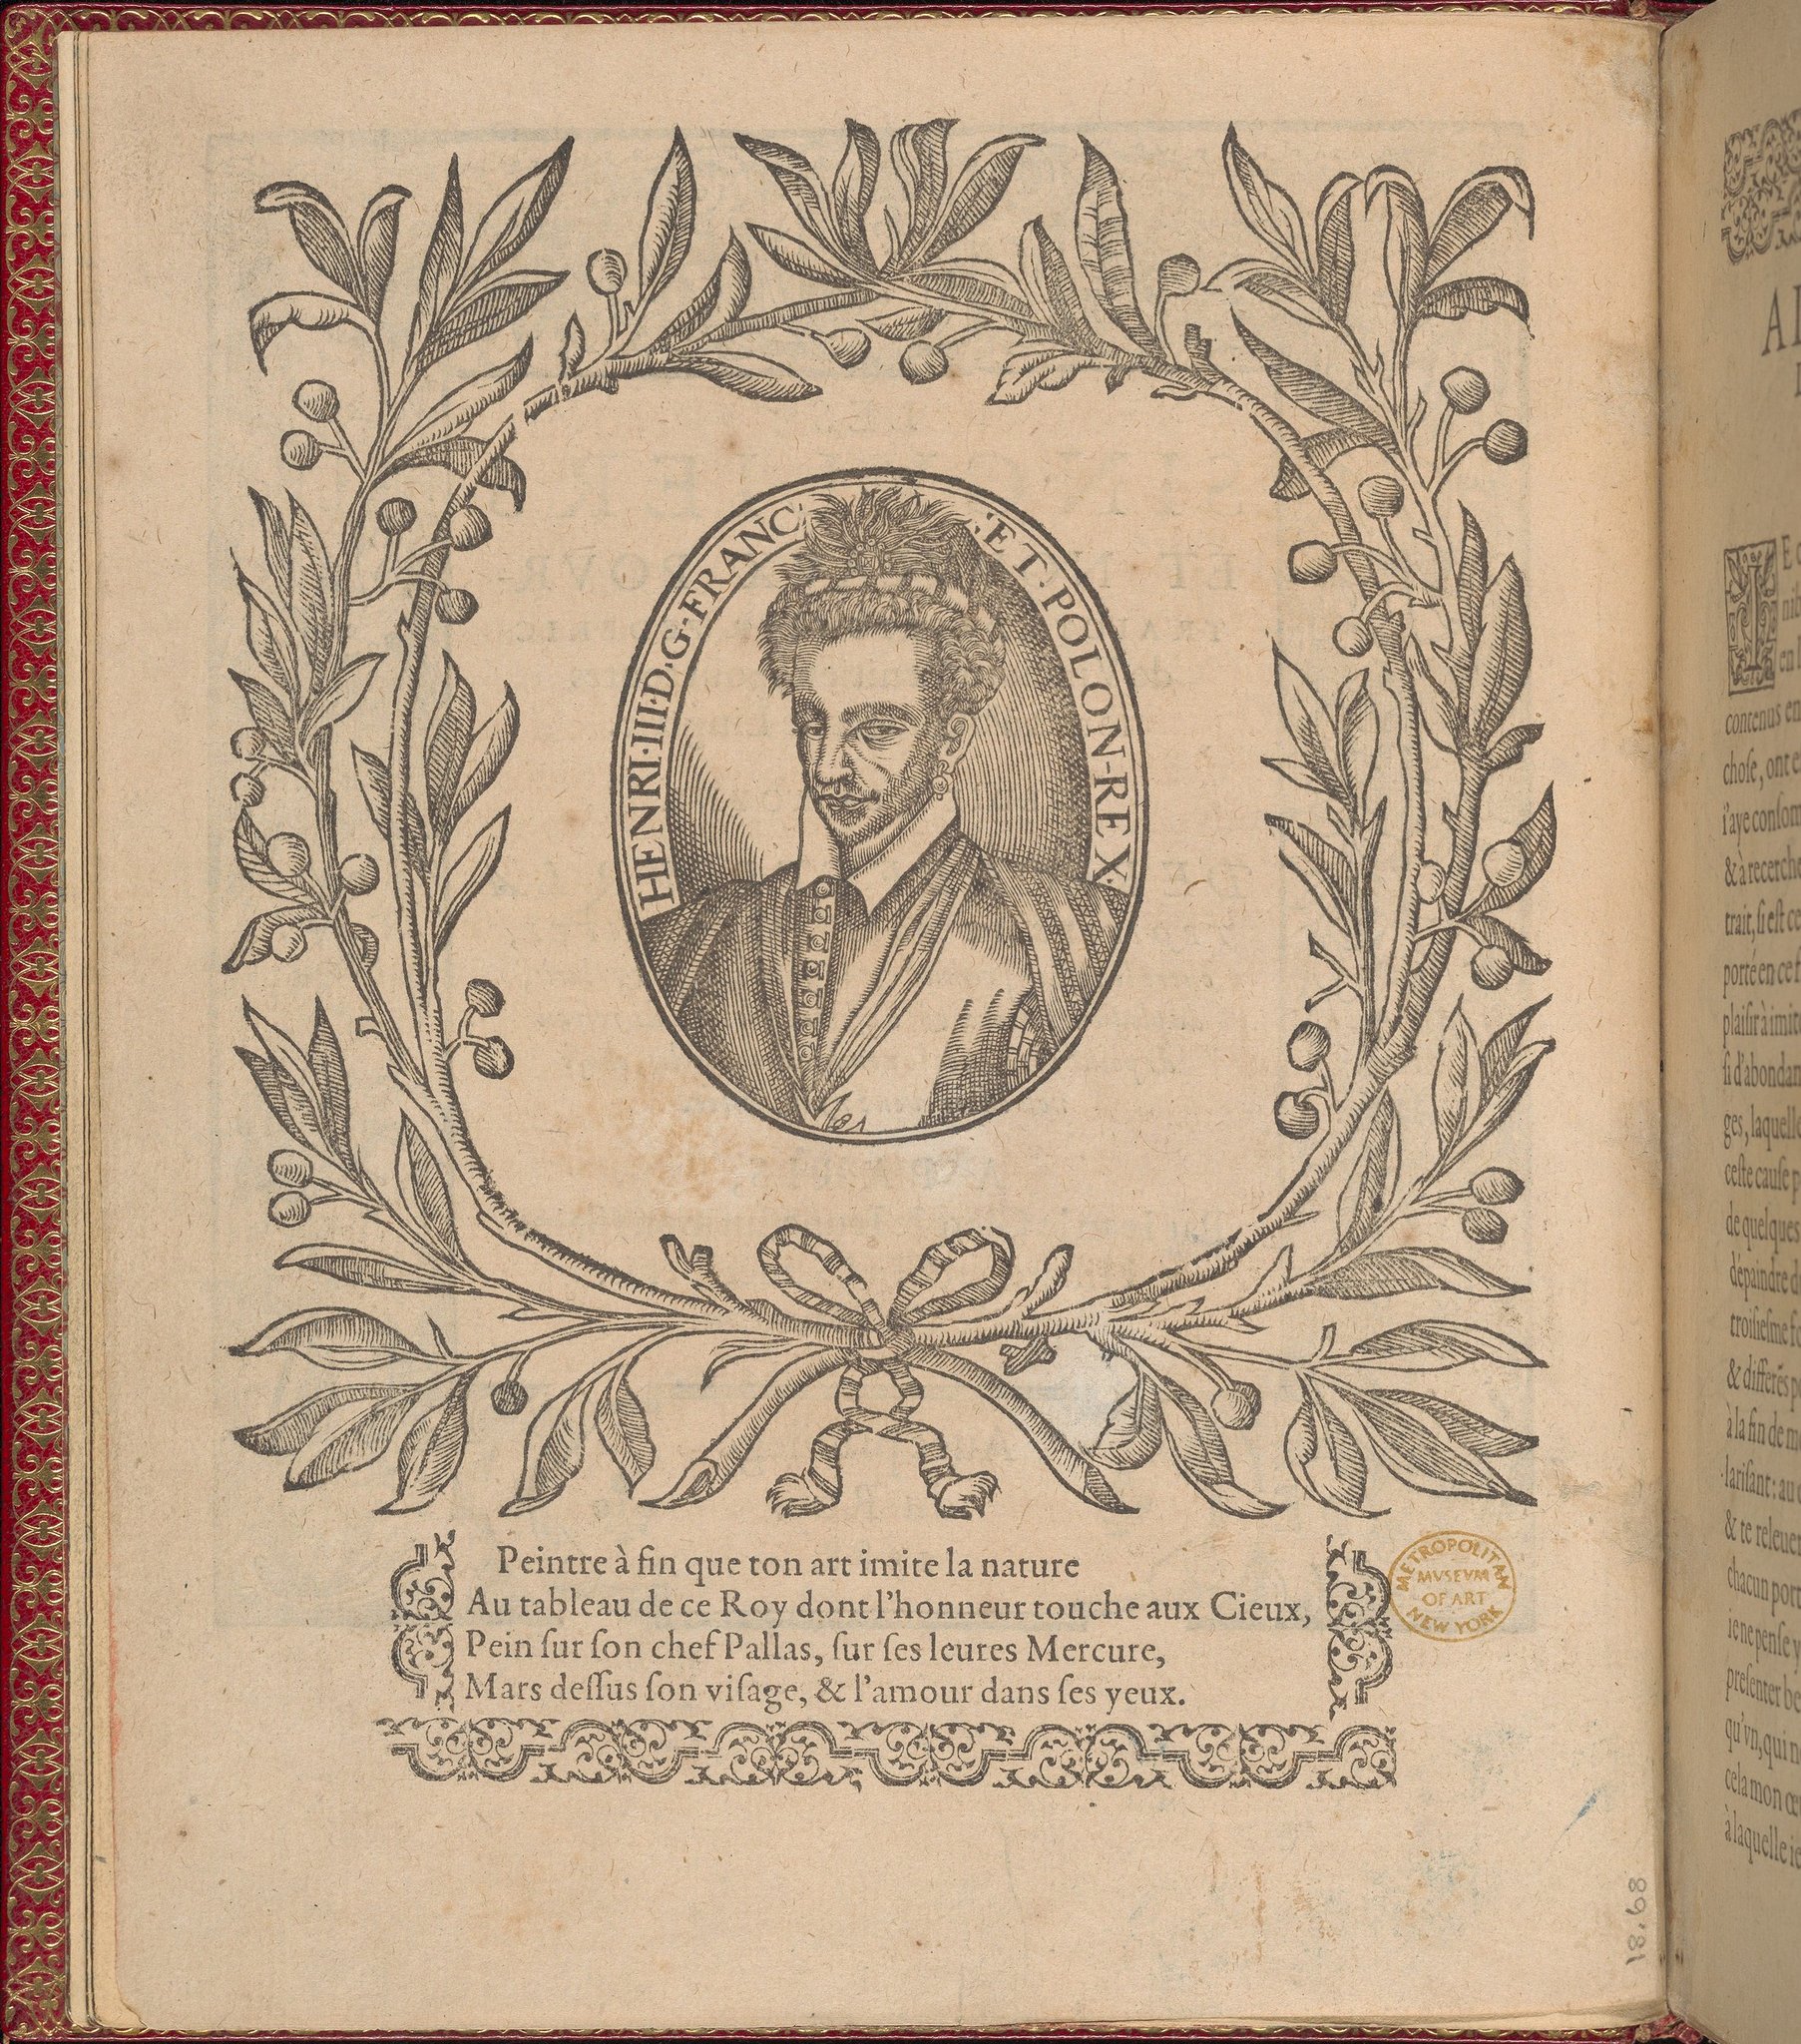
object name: book print ornament architecture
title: Les Singuliers et Nouveaux Portraicts... Part I title page (verso)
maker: federico de vinciolo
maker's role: designer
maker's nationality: italian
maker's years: 1582-1599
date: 1588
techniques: woodcut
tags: men,portraits,wreaths